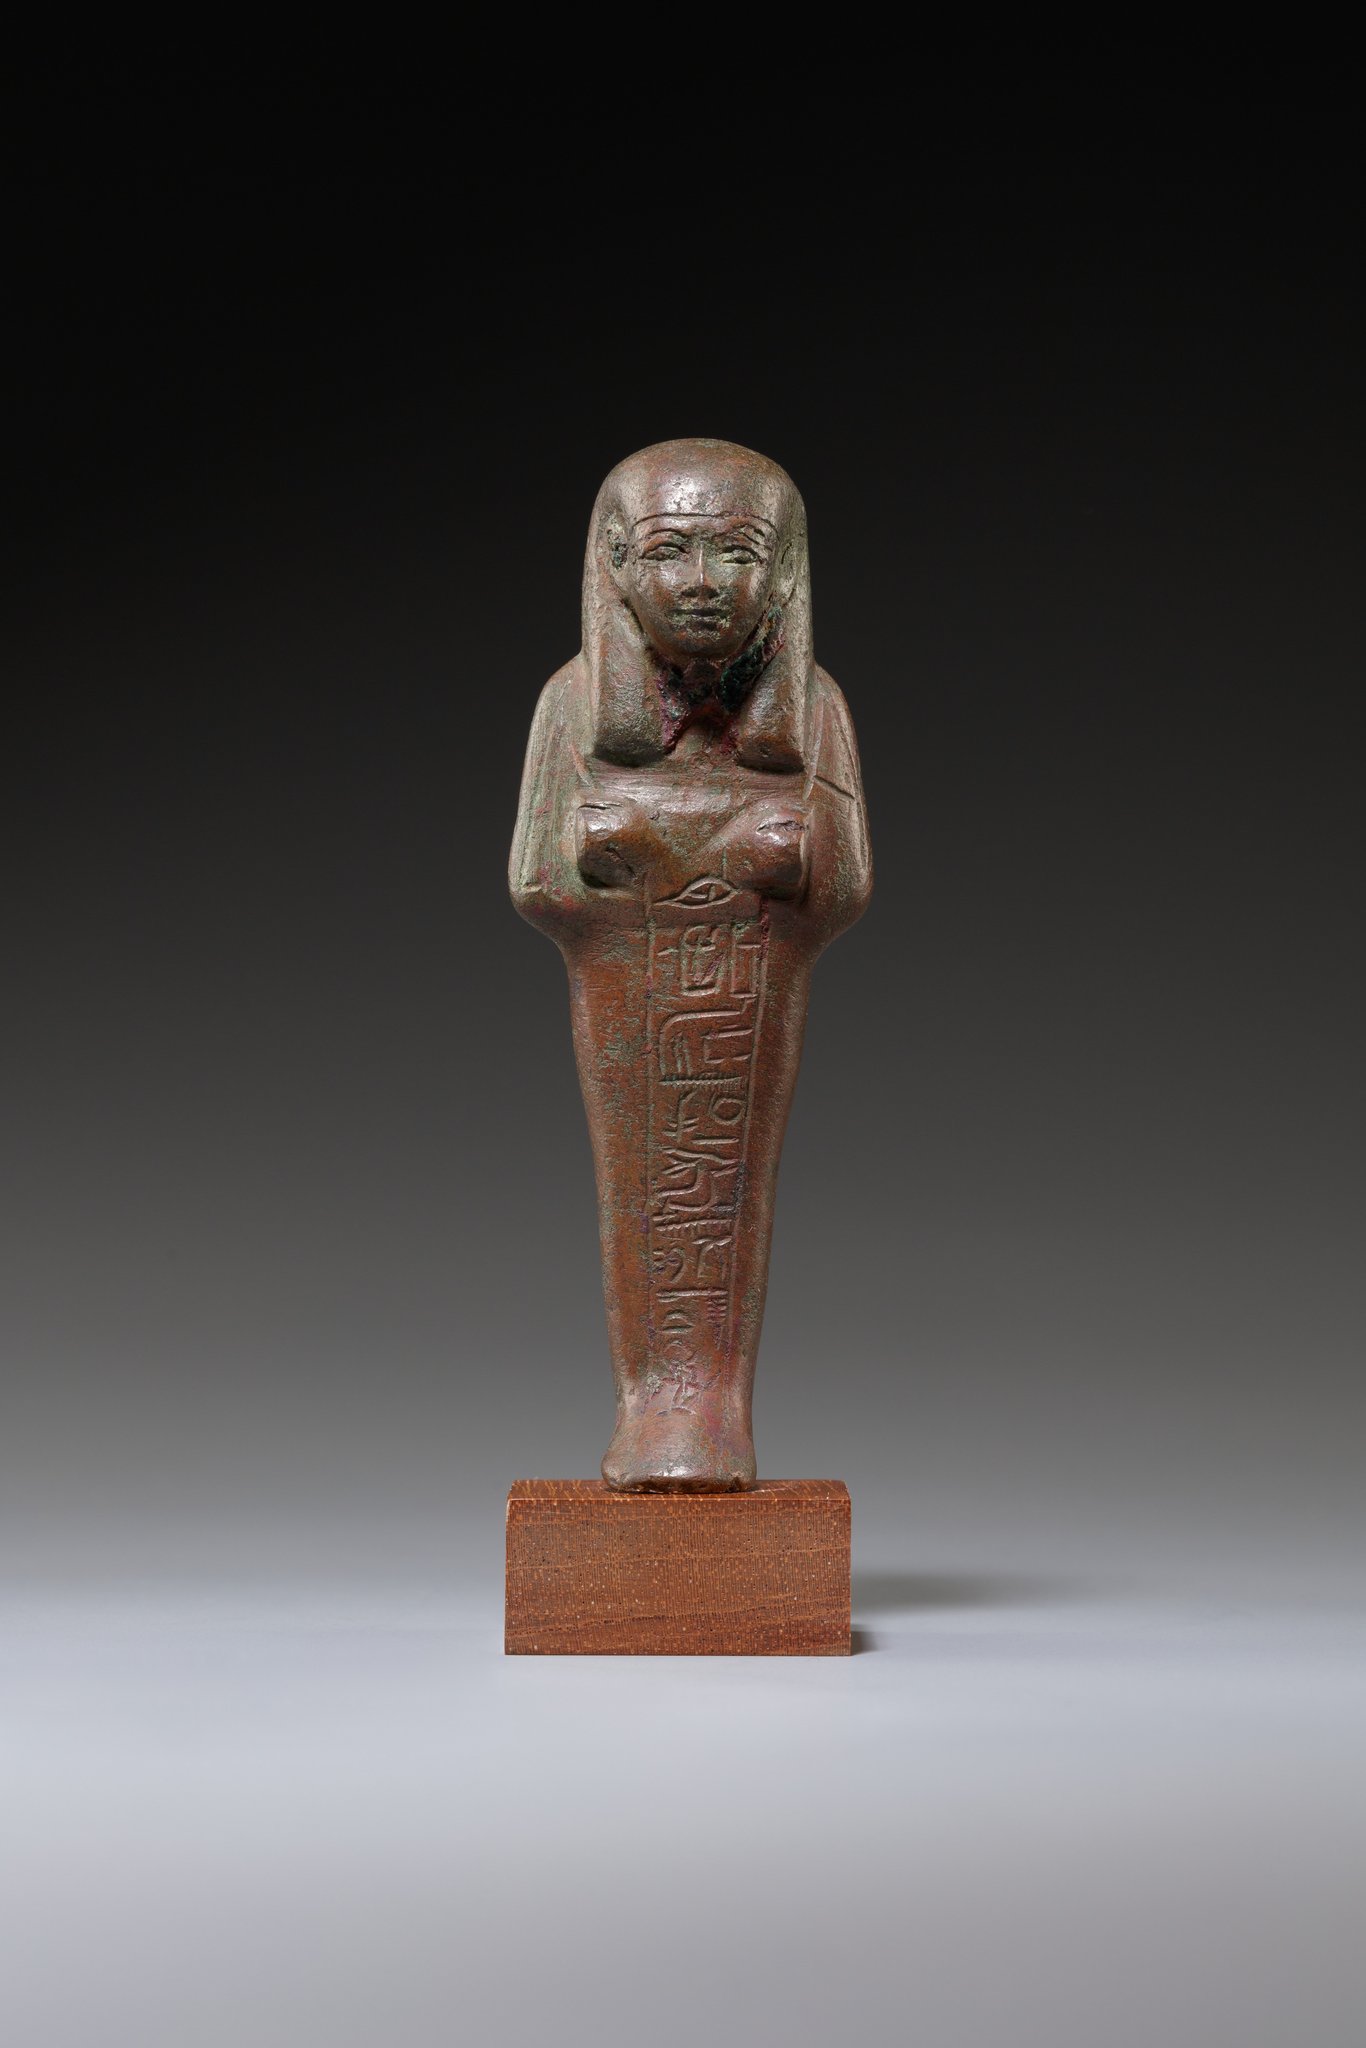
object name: shabti, wendjebauendjedet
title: Shabti of Wendjebauendjedet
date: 1040-992 BCE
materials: bronze, copper alloy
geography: egypt